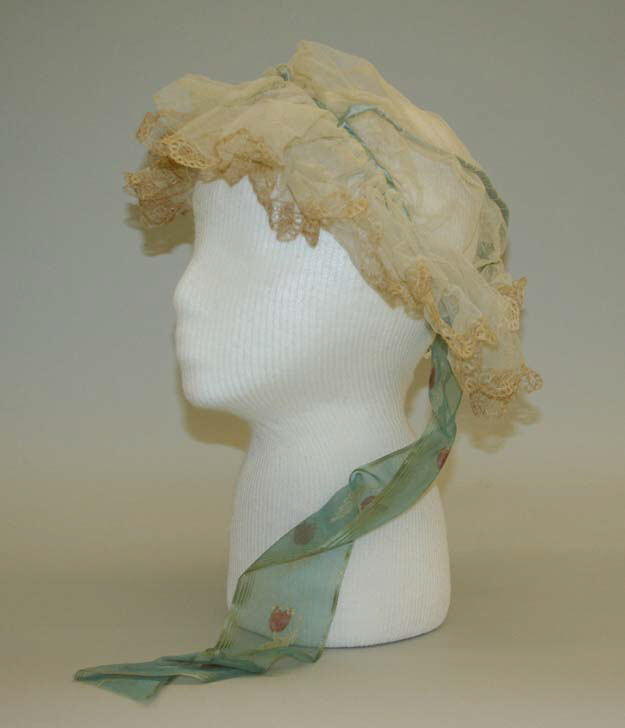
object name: cap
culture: american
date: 1830